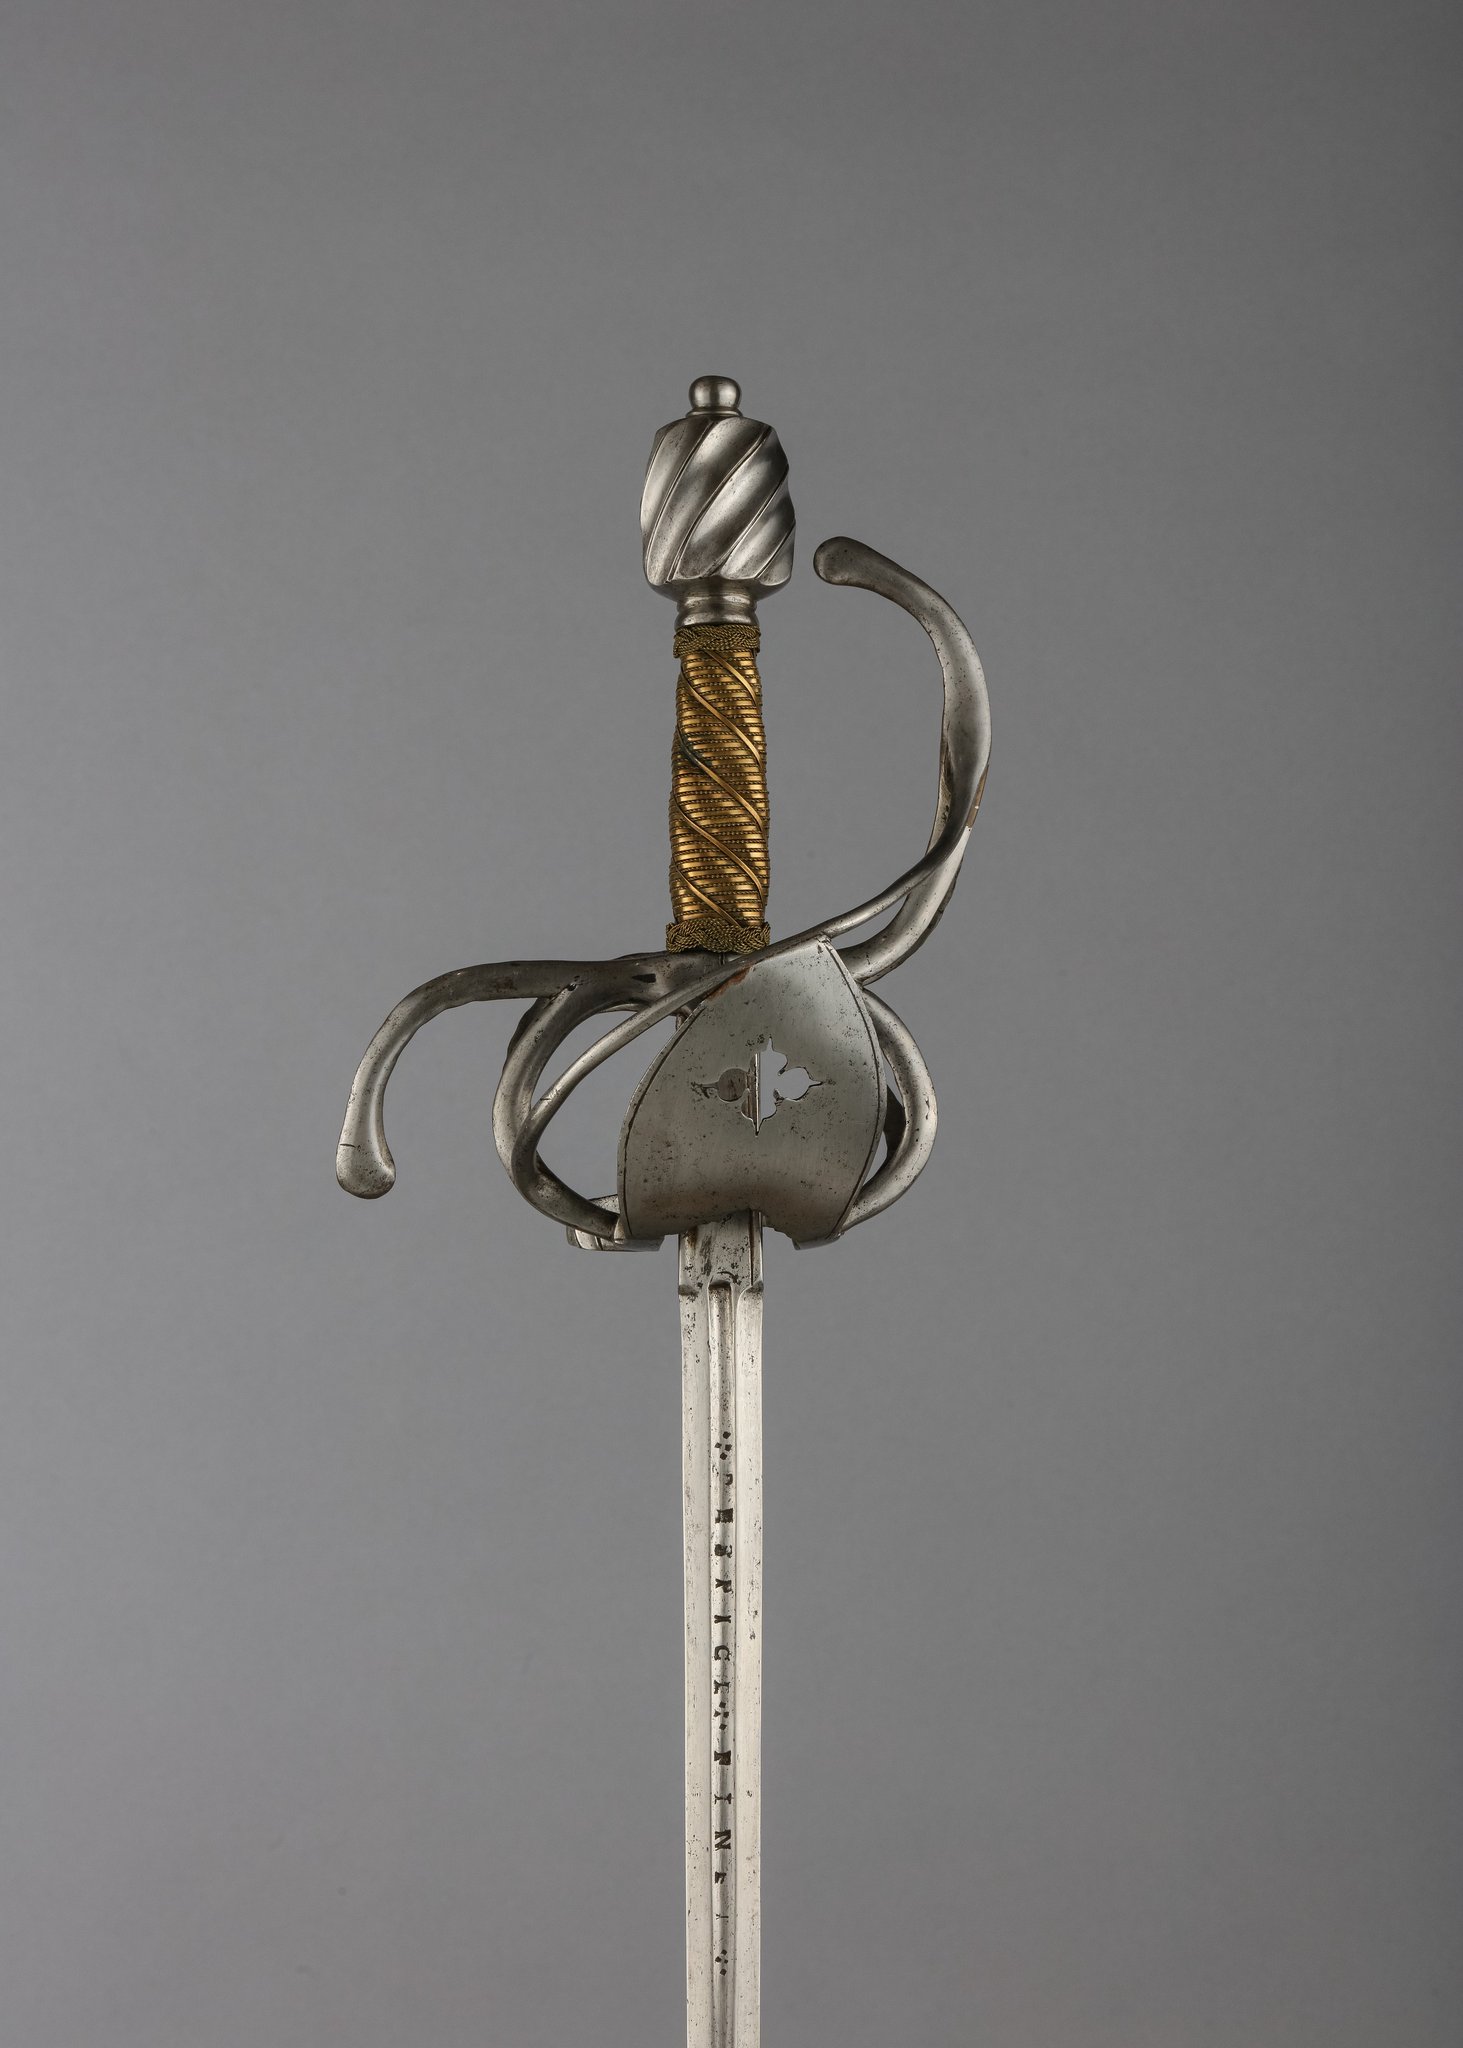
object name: rapier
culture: french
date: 1600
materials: brass, steel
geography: france